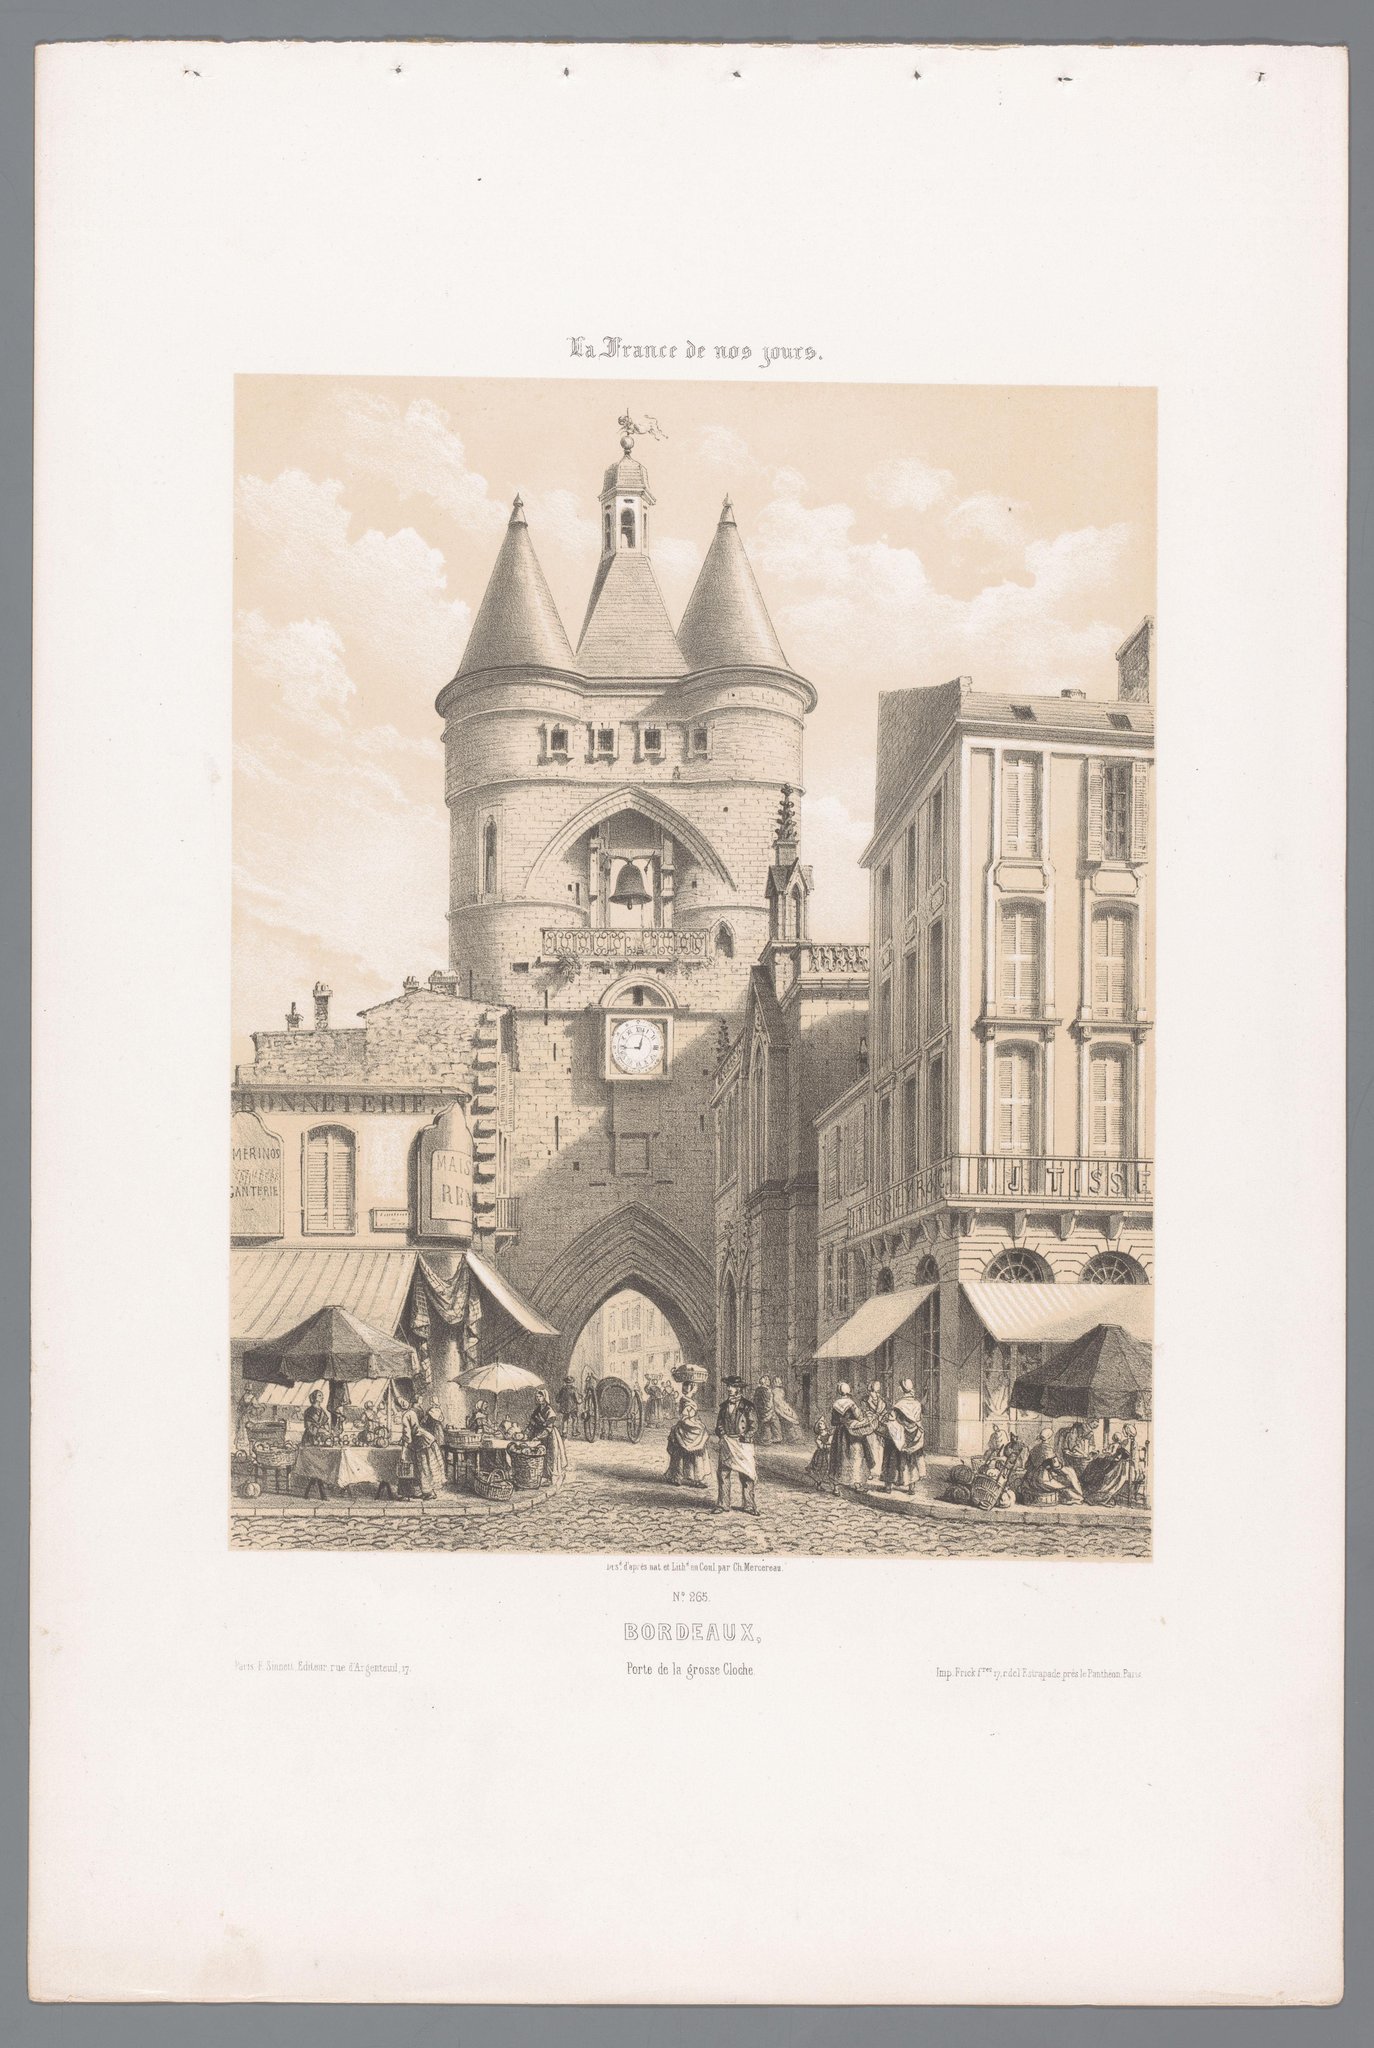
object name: print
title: Gezicht op de Porte de la Grosse Cloche te Bordeaux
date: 1856-1874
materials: paper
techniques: tone lithography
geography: paris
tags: city-view, and landscape with man-made constructions, bell ~ musical instruments - cc - out of doors, clock, city-gate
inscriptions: collector's mark: Lugt 2228